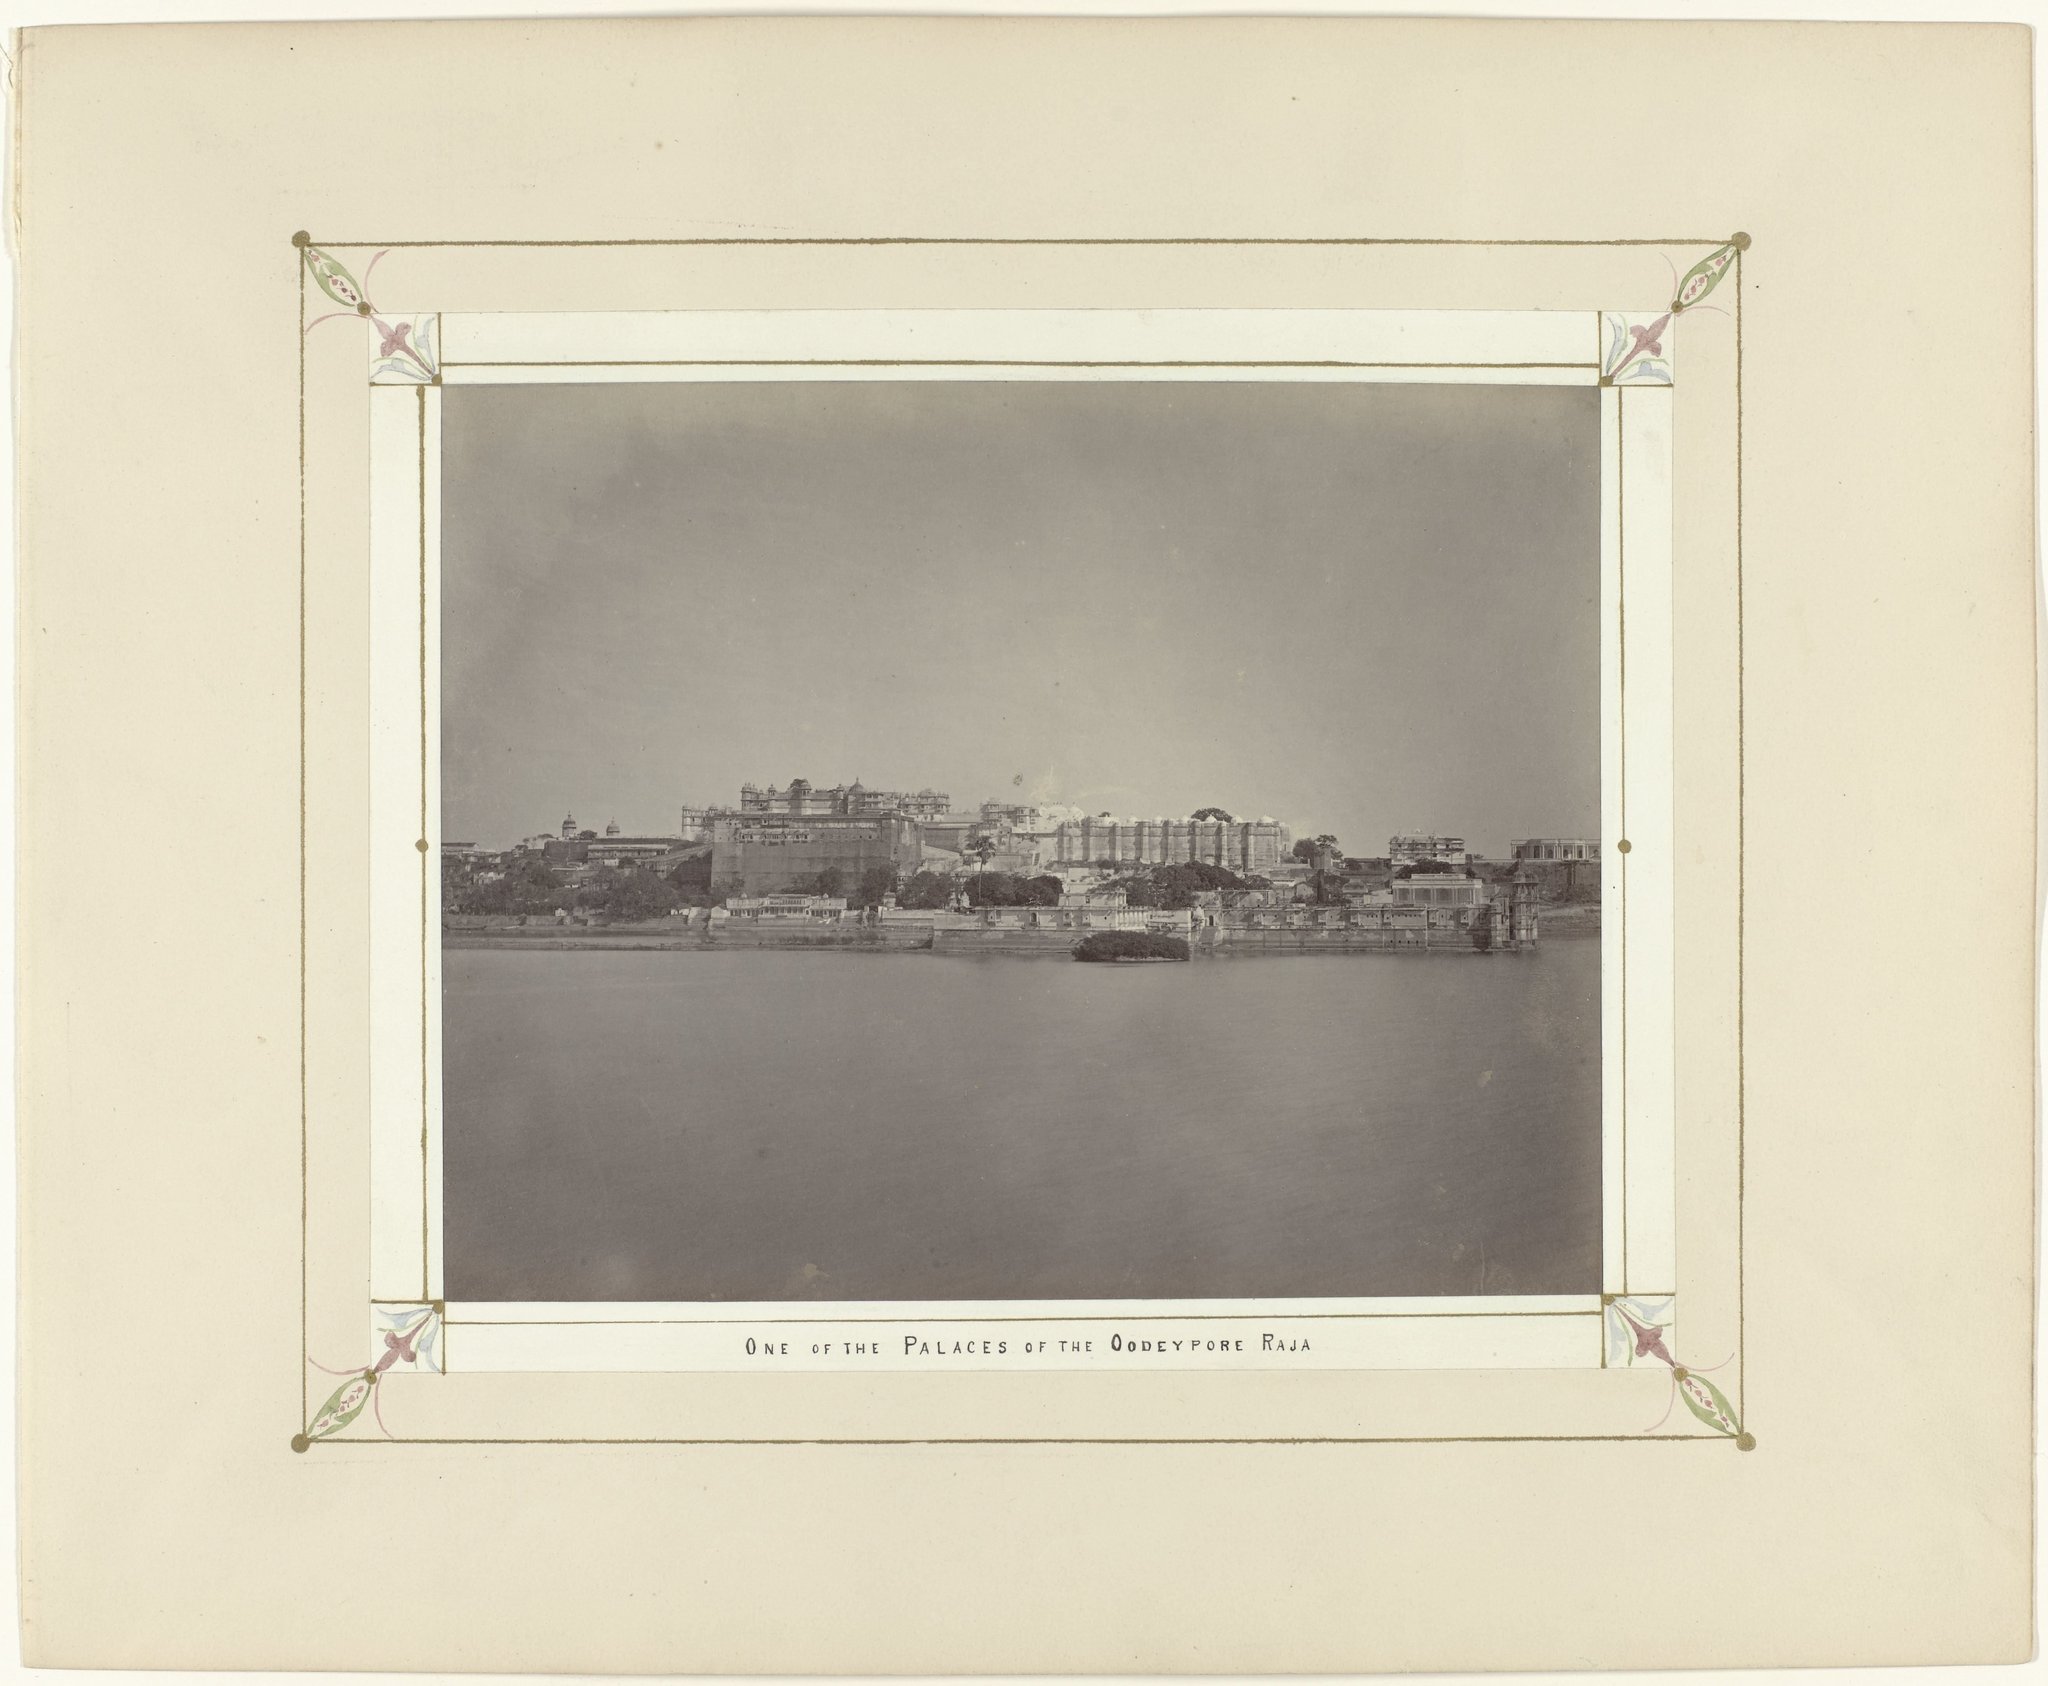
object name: photograph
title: City Palace of Udaipur, Rajasthan, India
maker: Anonymous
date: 1860-1890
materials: paper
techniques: albumen print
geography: udaipur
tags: palace, lake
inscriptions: inscription: ‘The White Marble Palace of the Oodeypore Raja./ Inside full of Orange trees.’